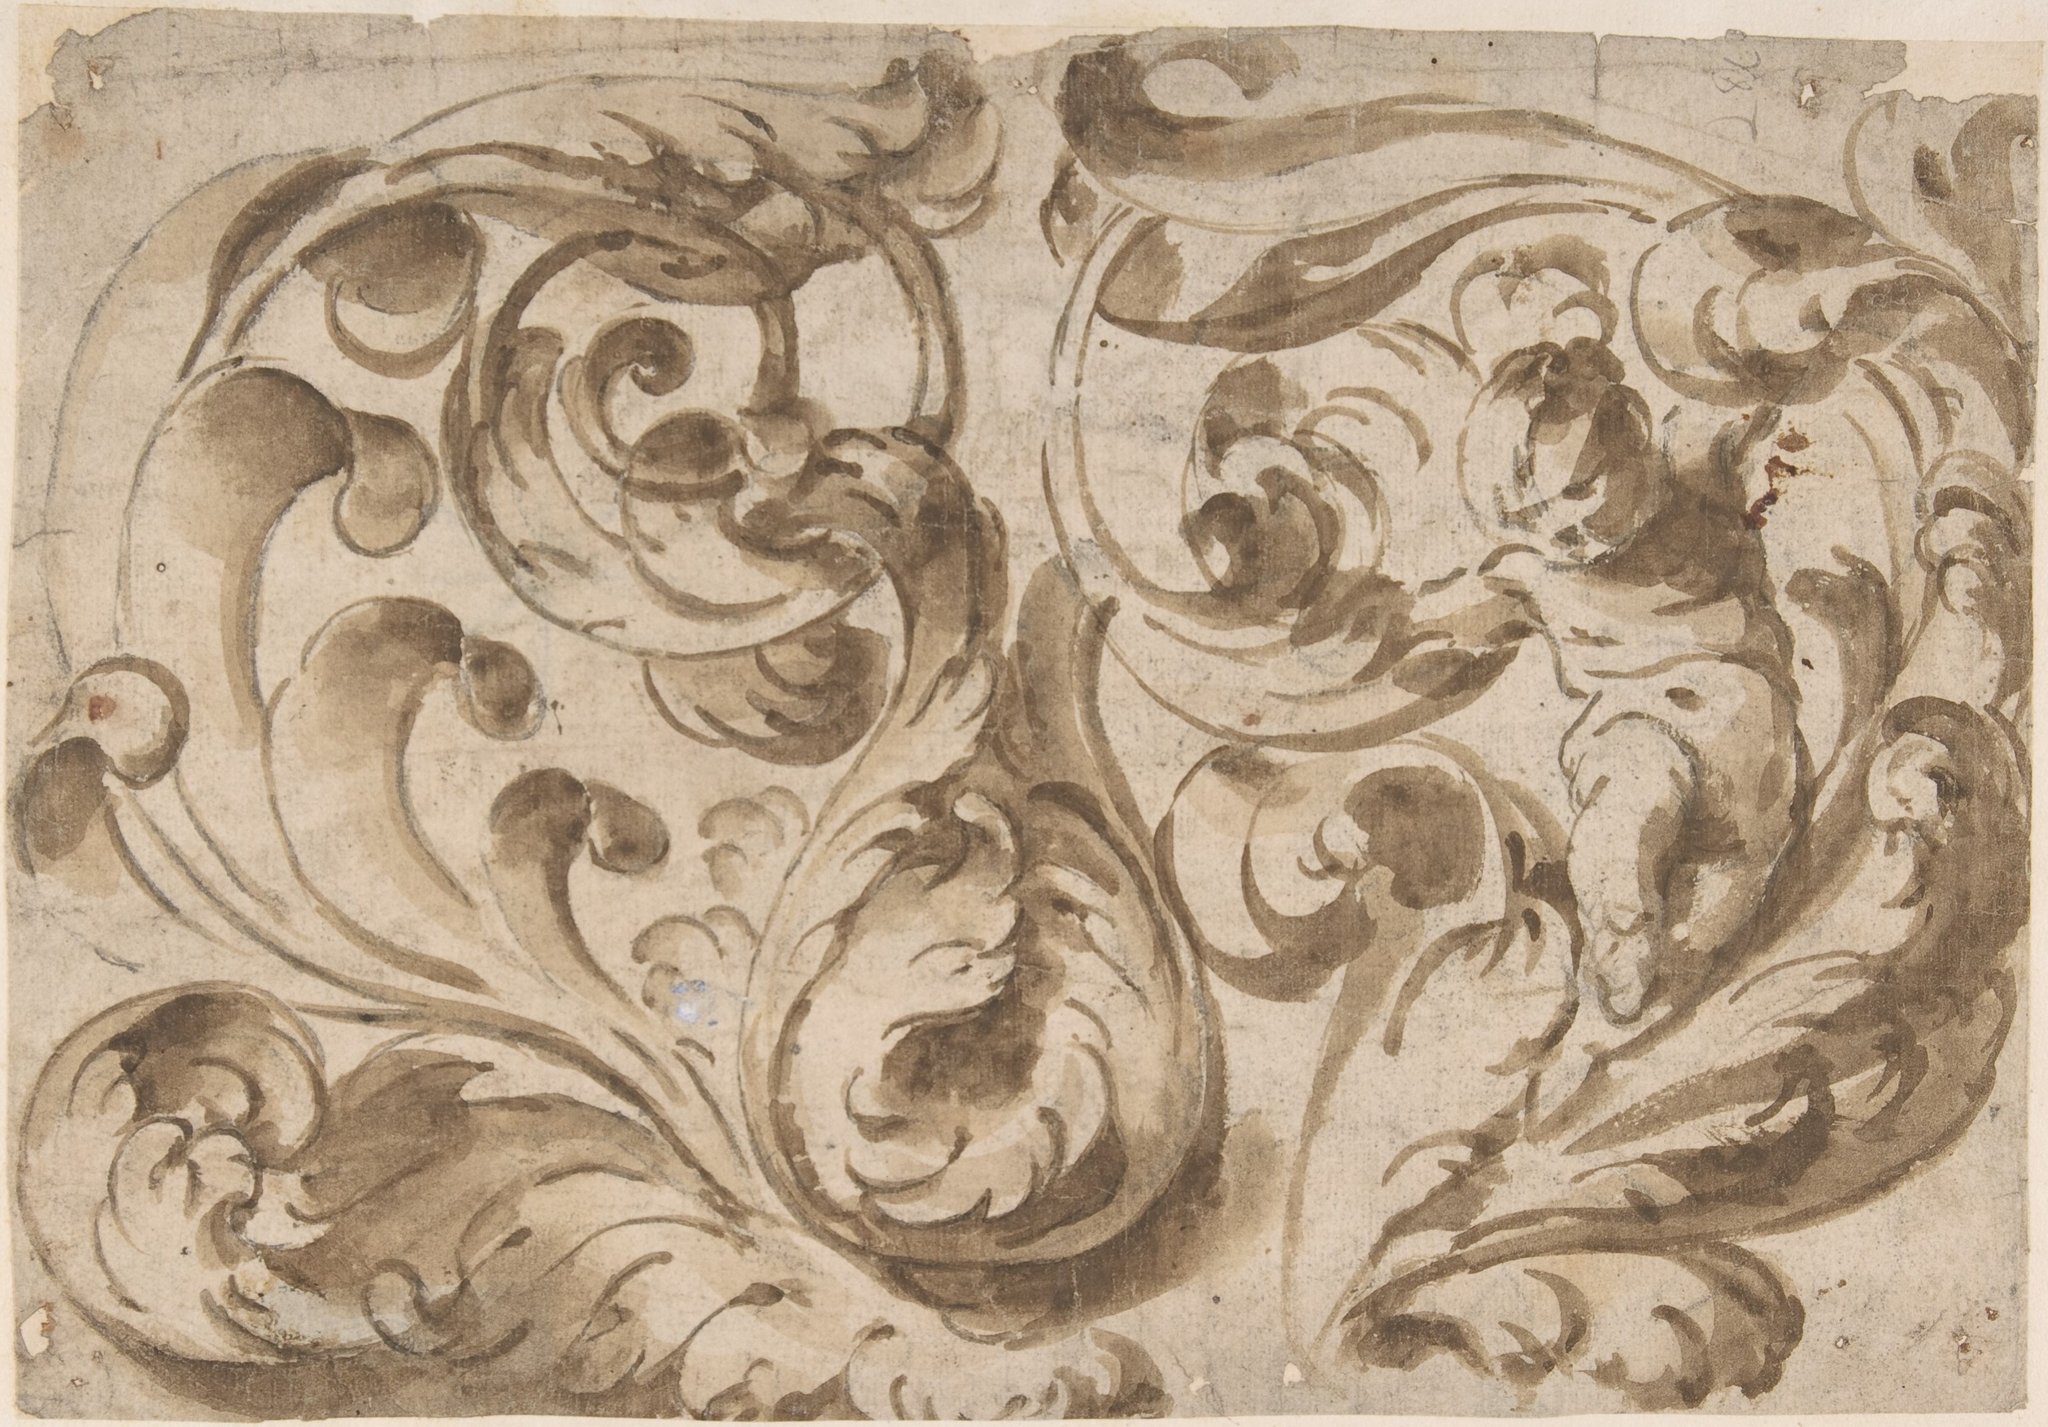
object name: drawing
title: Overall Pattern with Acanthus Scrolls and a Chubby Putto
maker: anonymous, italian, 17th century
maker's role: artist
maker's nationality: italian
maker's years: 1600-1700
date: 1601-1700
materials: graphite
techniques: brush, wash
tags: ornament